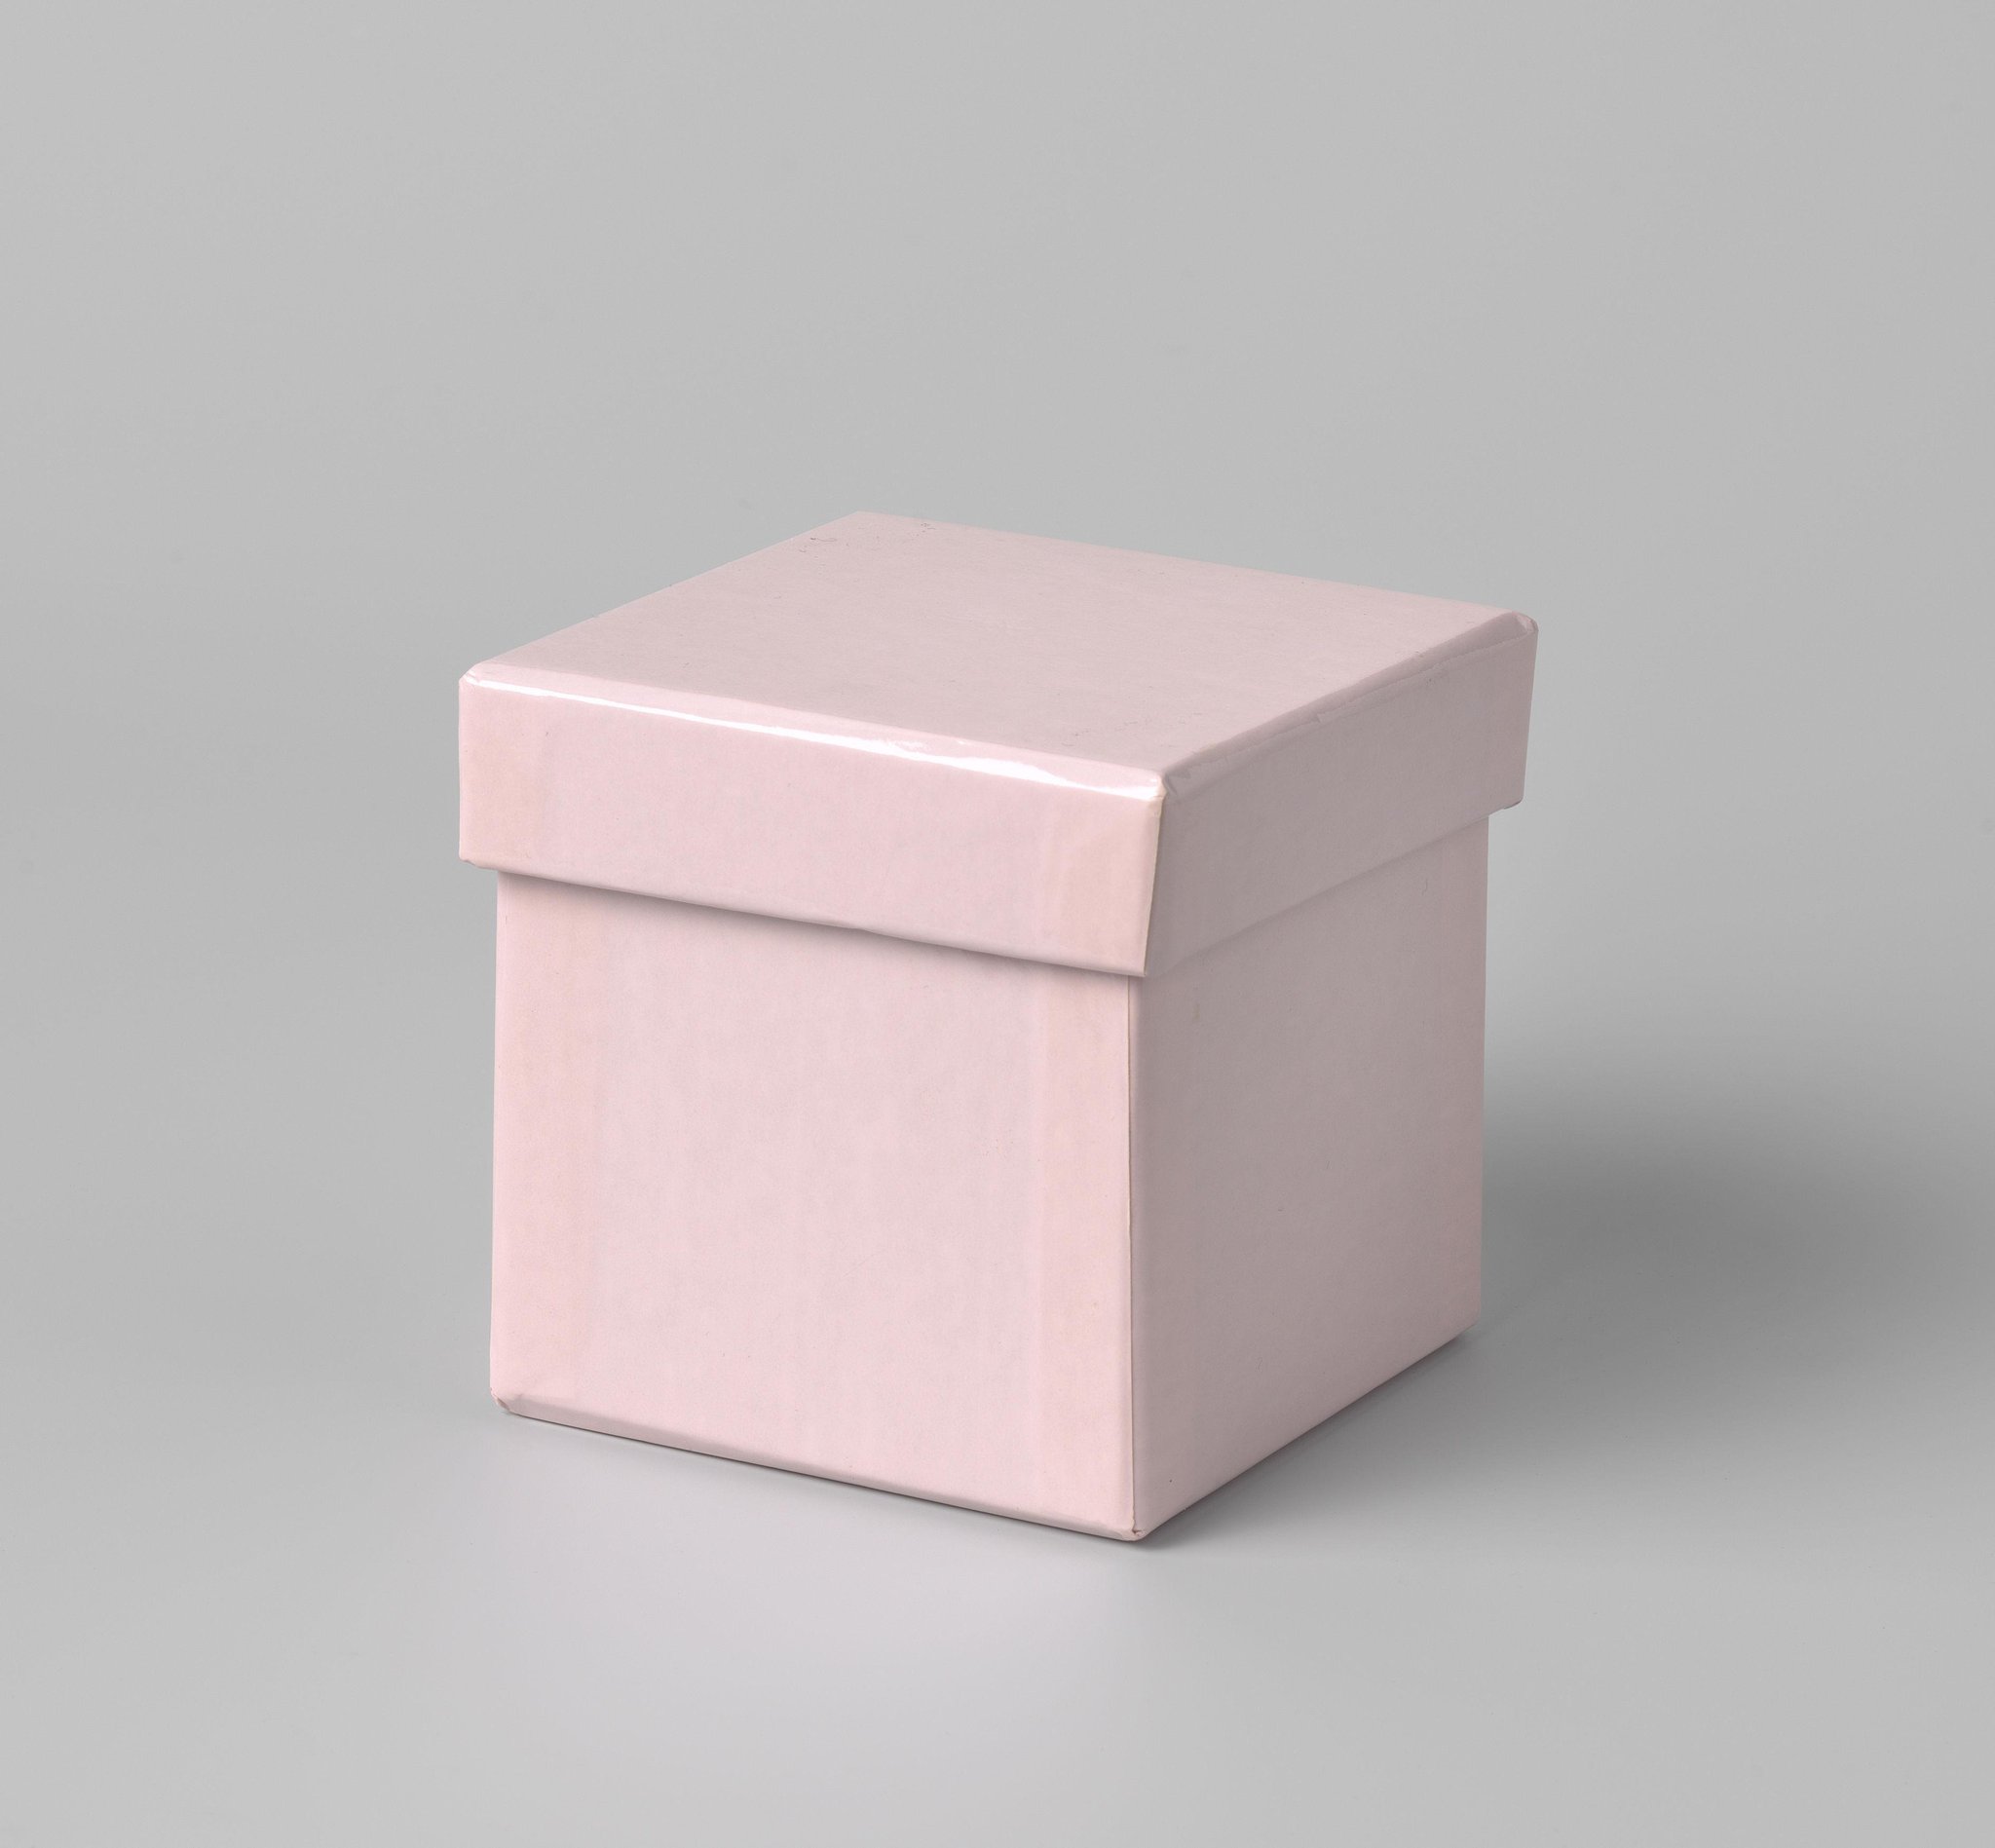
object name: box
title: Doos voor Perlensau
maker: david bielander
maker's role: designer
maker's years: 1968-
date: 2003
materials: cardboard, felt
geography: germany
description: Vierkante roze doos van karton met los deksel. Aan de binnenzijde van de deksel staat een afbeelding van een naaktslak.